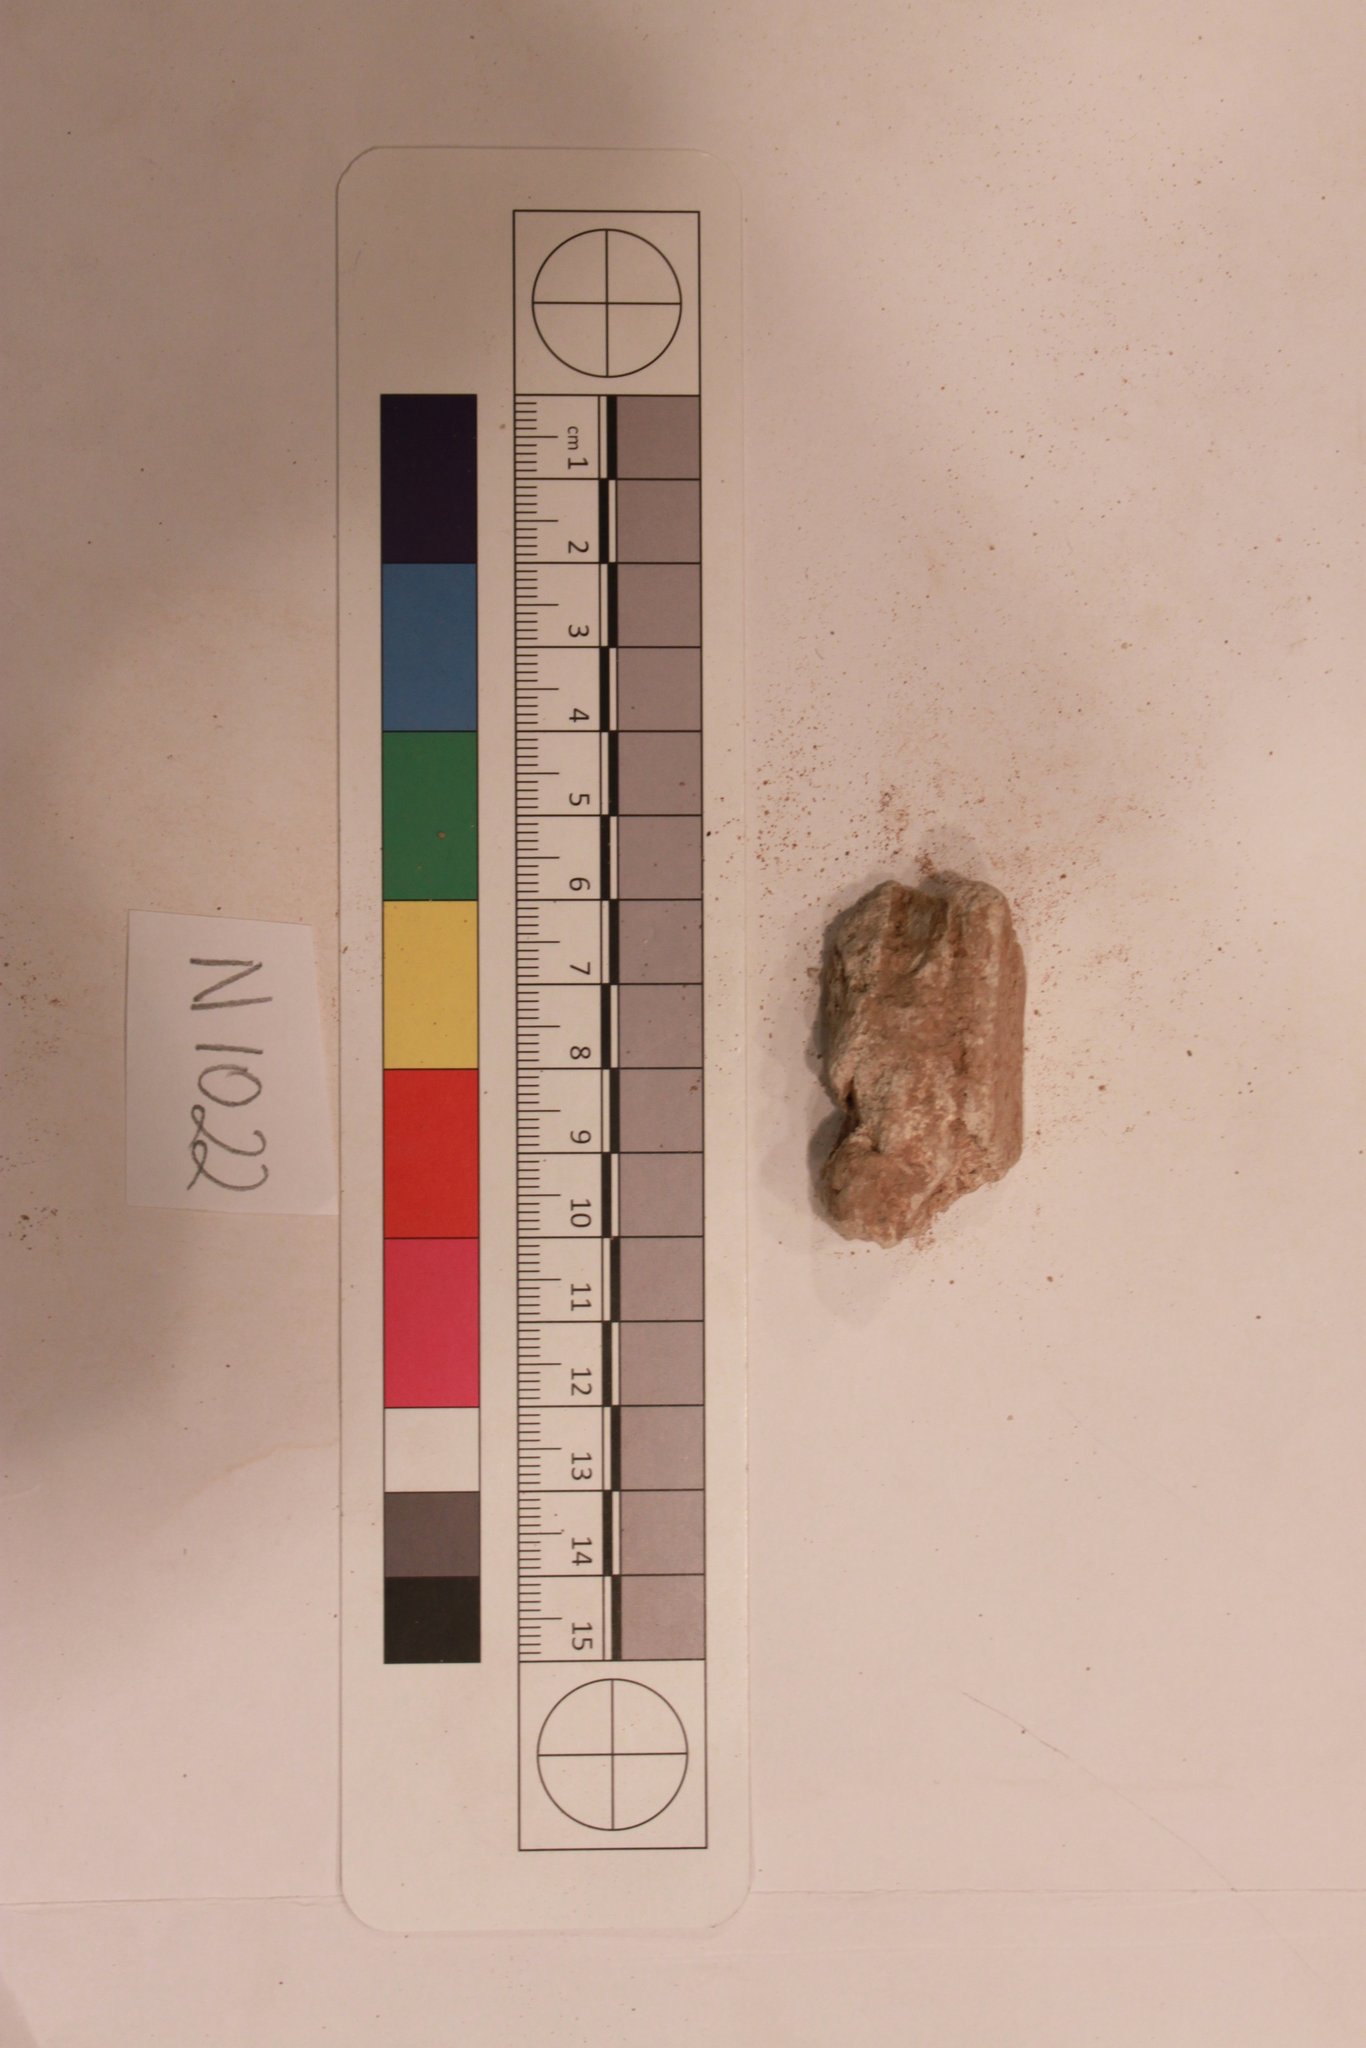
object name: fragment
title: Stucco Fragment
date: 701-1200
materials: plaster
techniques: carving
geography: iran